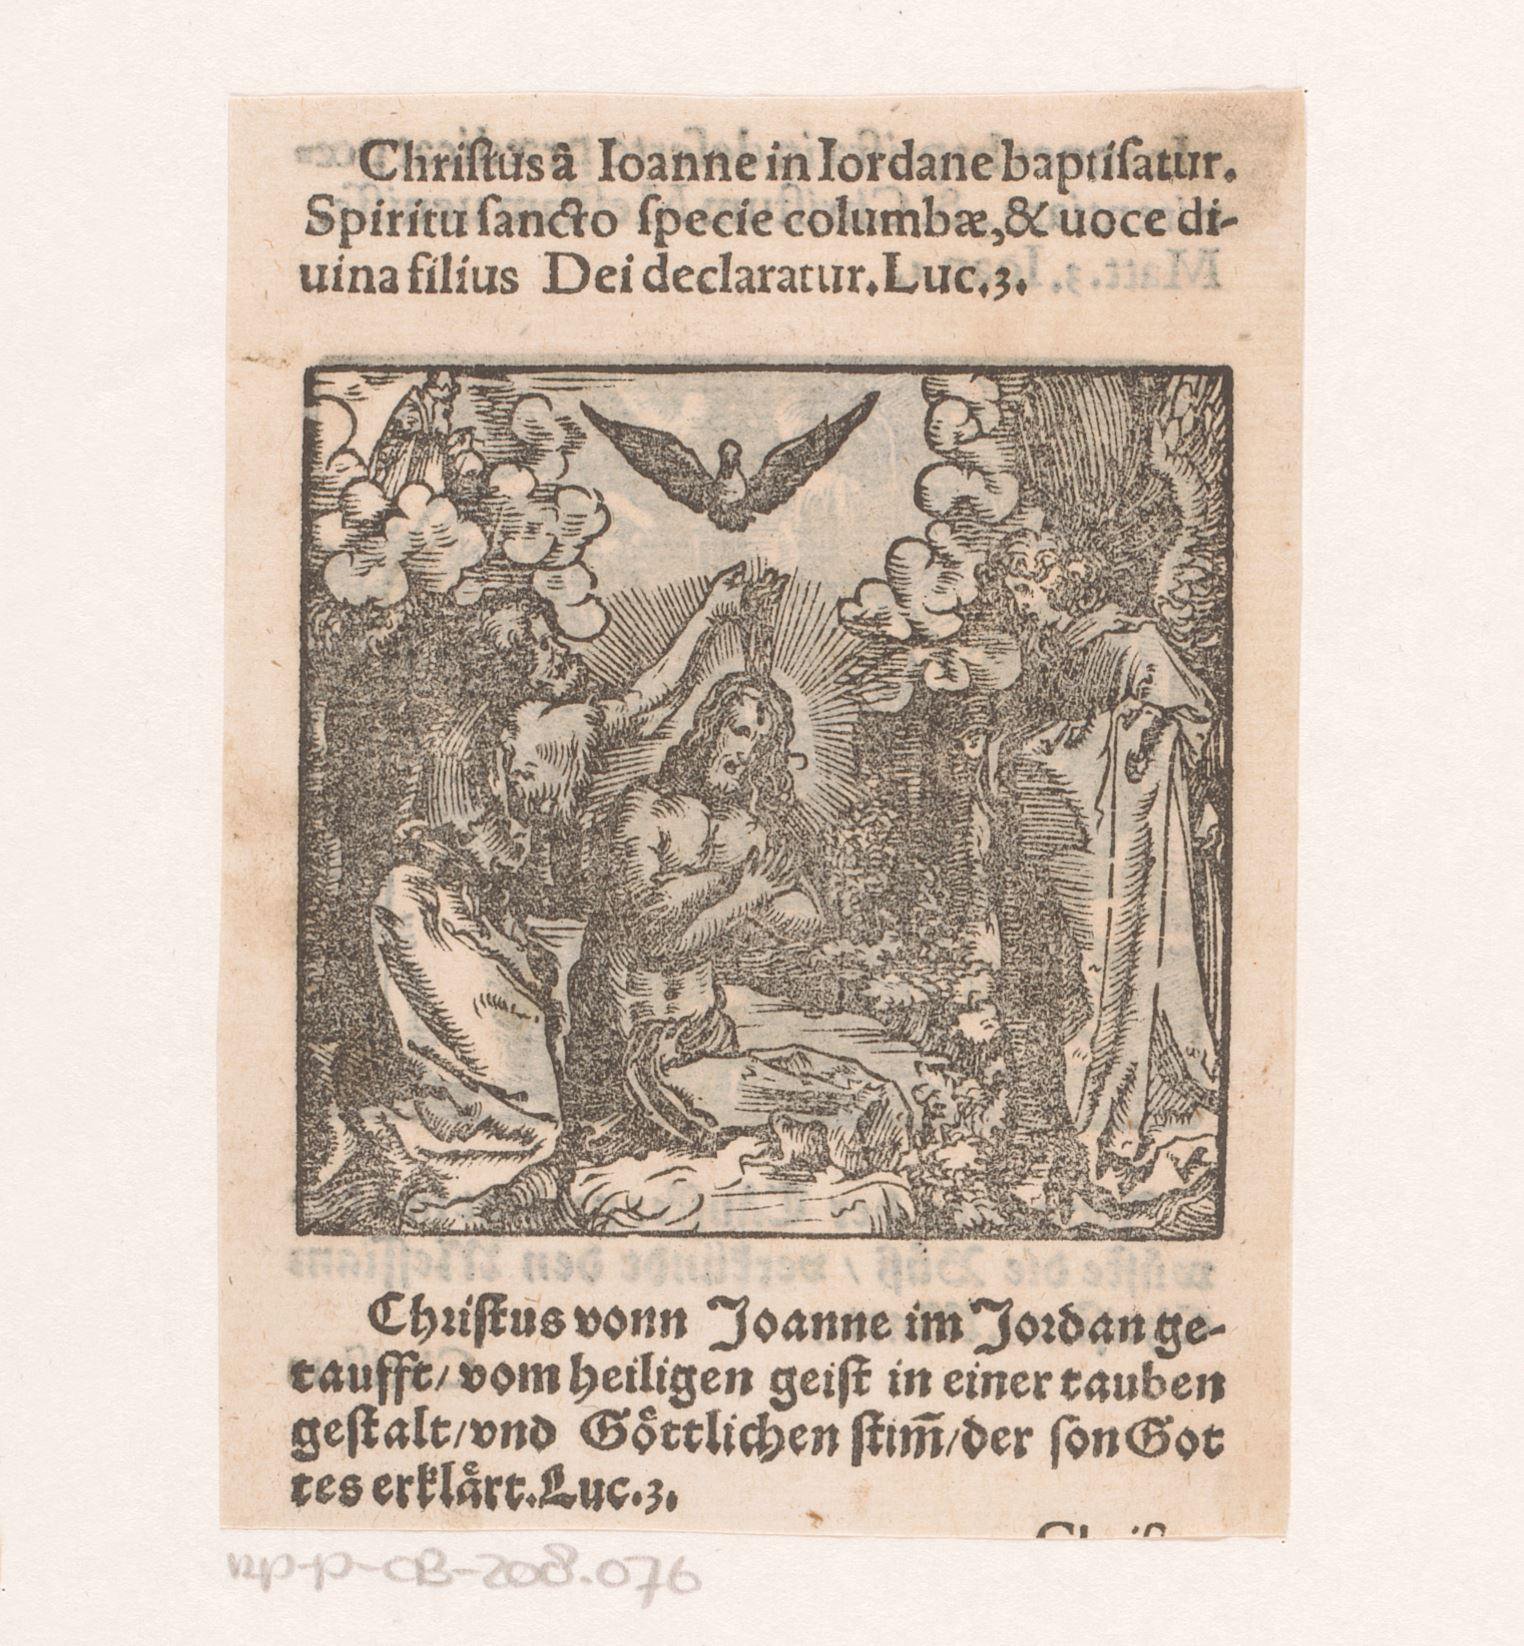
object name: print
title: Doop van Christus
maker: Anonymous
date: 1600-1699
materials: paper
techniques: letterpress printing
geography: netherlands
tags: baptism of christ in the river jordan: john the baptist pouring out water on christ's head: the holy ghost descends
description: Johannes de Doper doopt Christus in de Jordaan. De Heilige Geest daalt als een duif op hem neer.